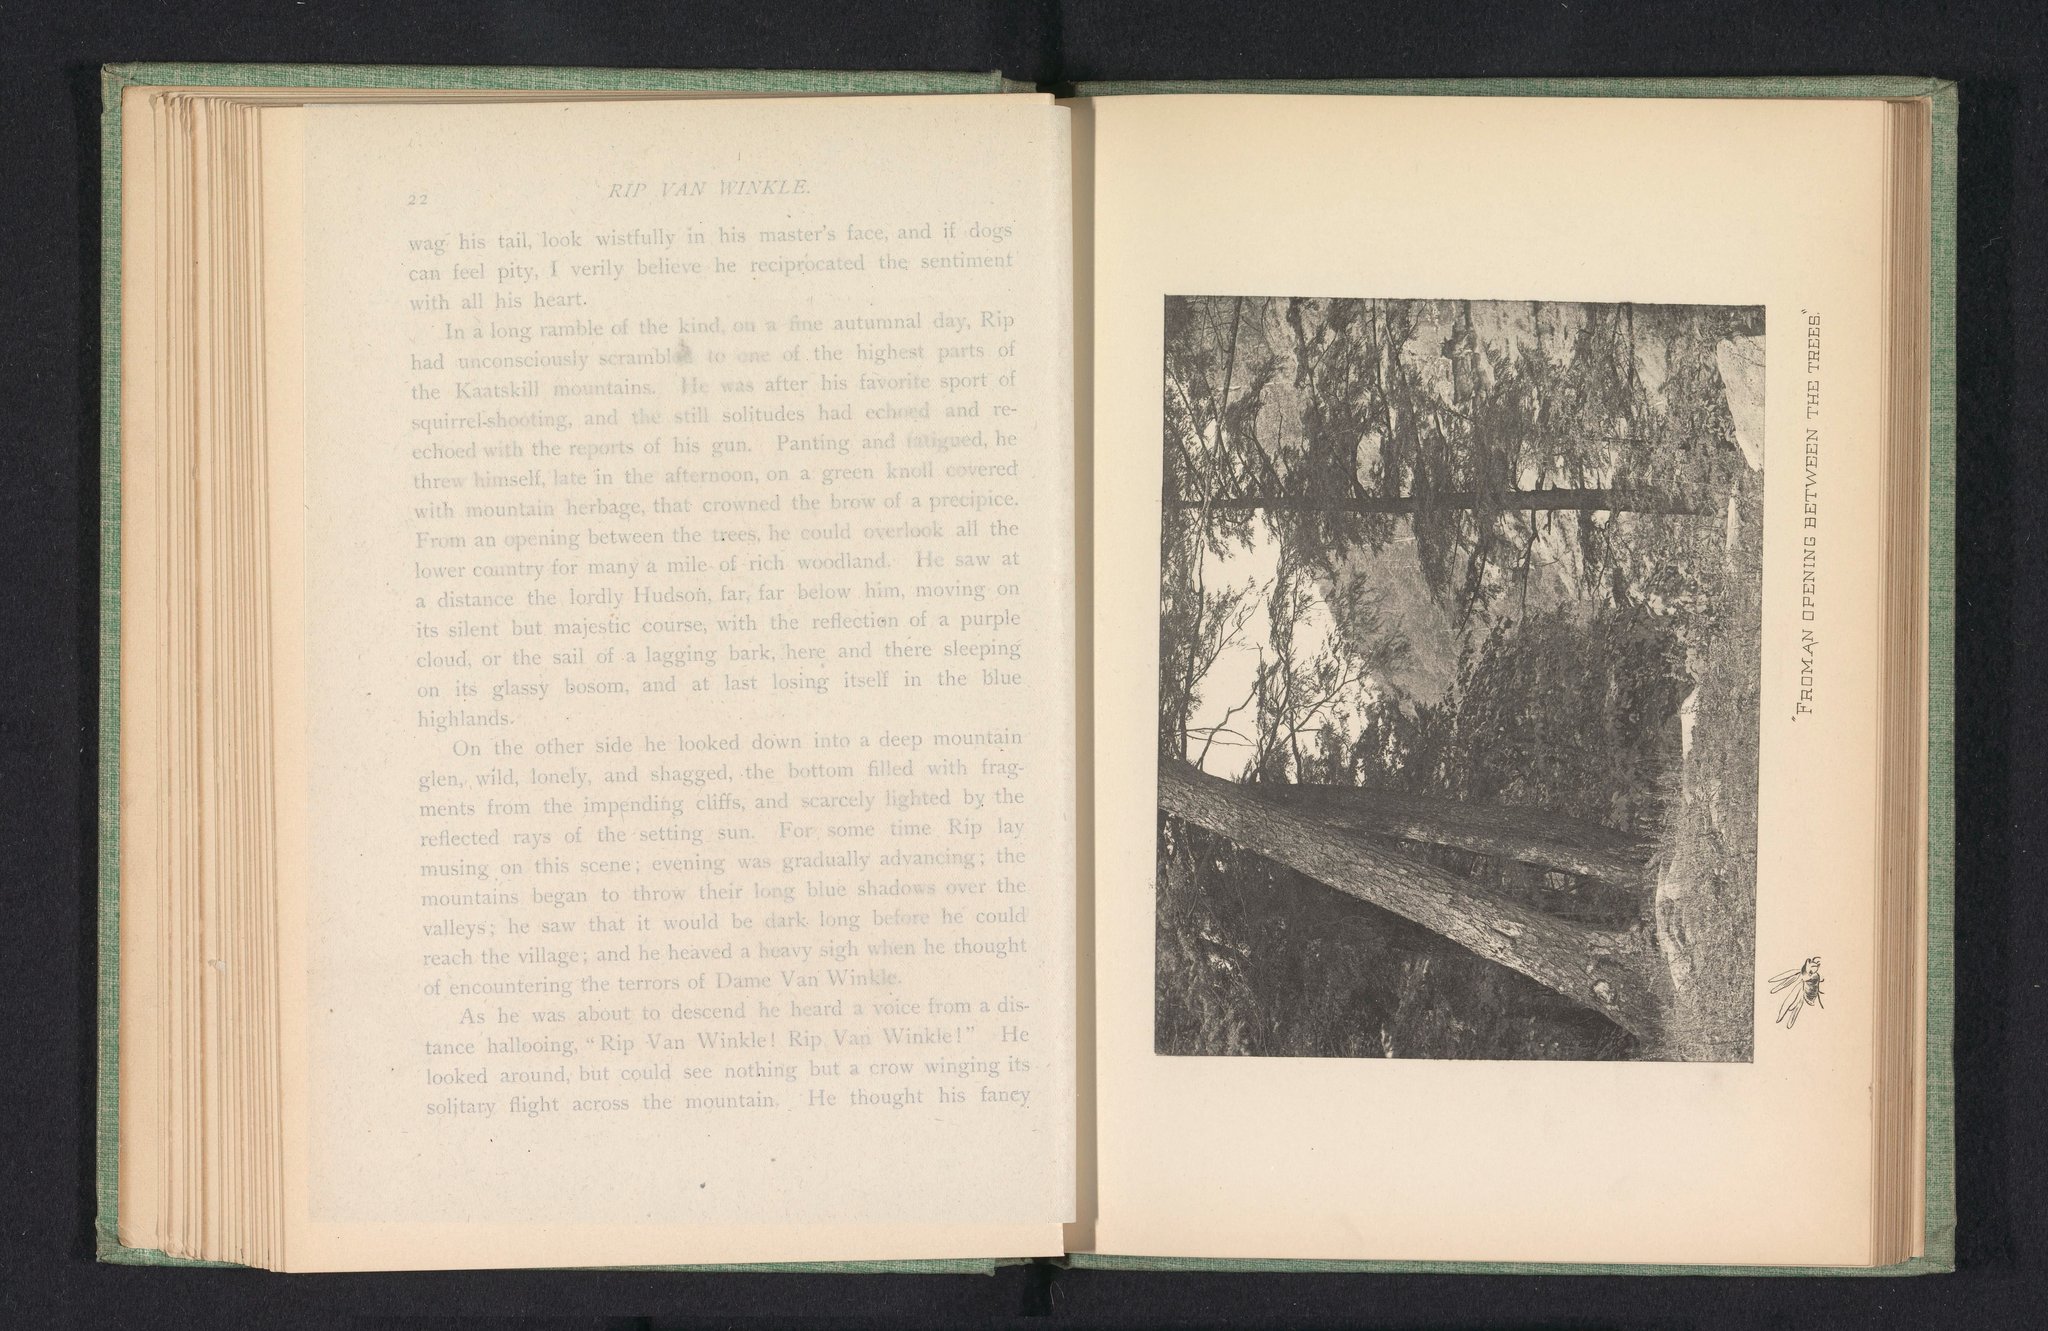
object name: page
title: Gezicht op bos en bergen in het Catskillgebergte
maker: Anonymous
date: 1884-1894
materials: paper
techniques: photoaquatint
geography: catskill mountains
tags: forest, wood, mountains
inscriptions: inscription: ‘“From an opening between the trees.”’